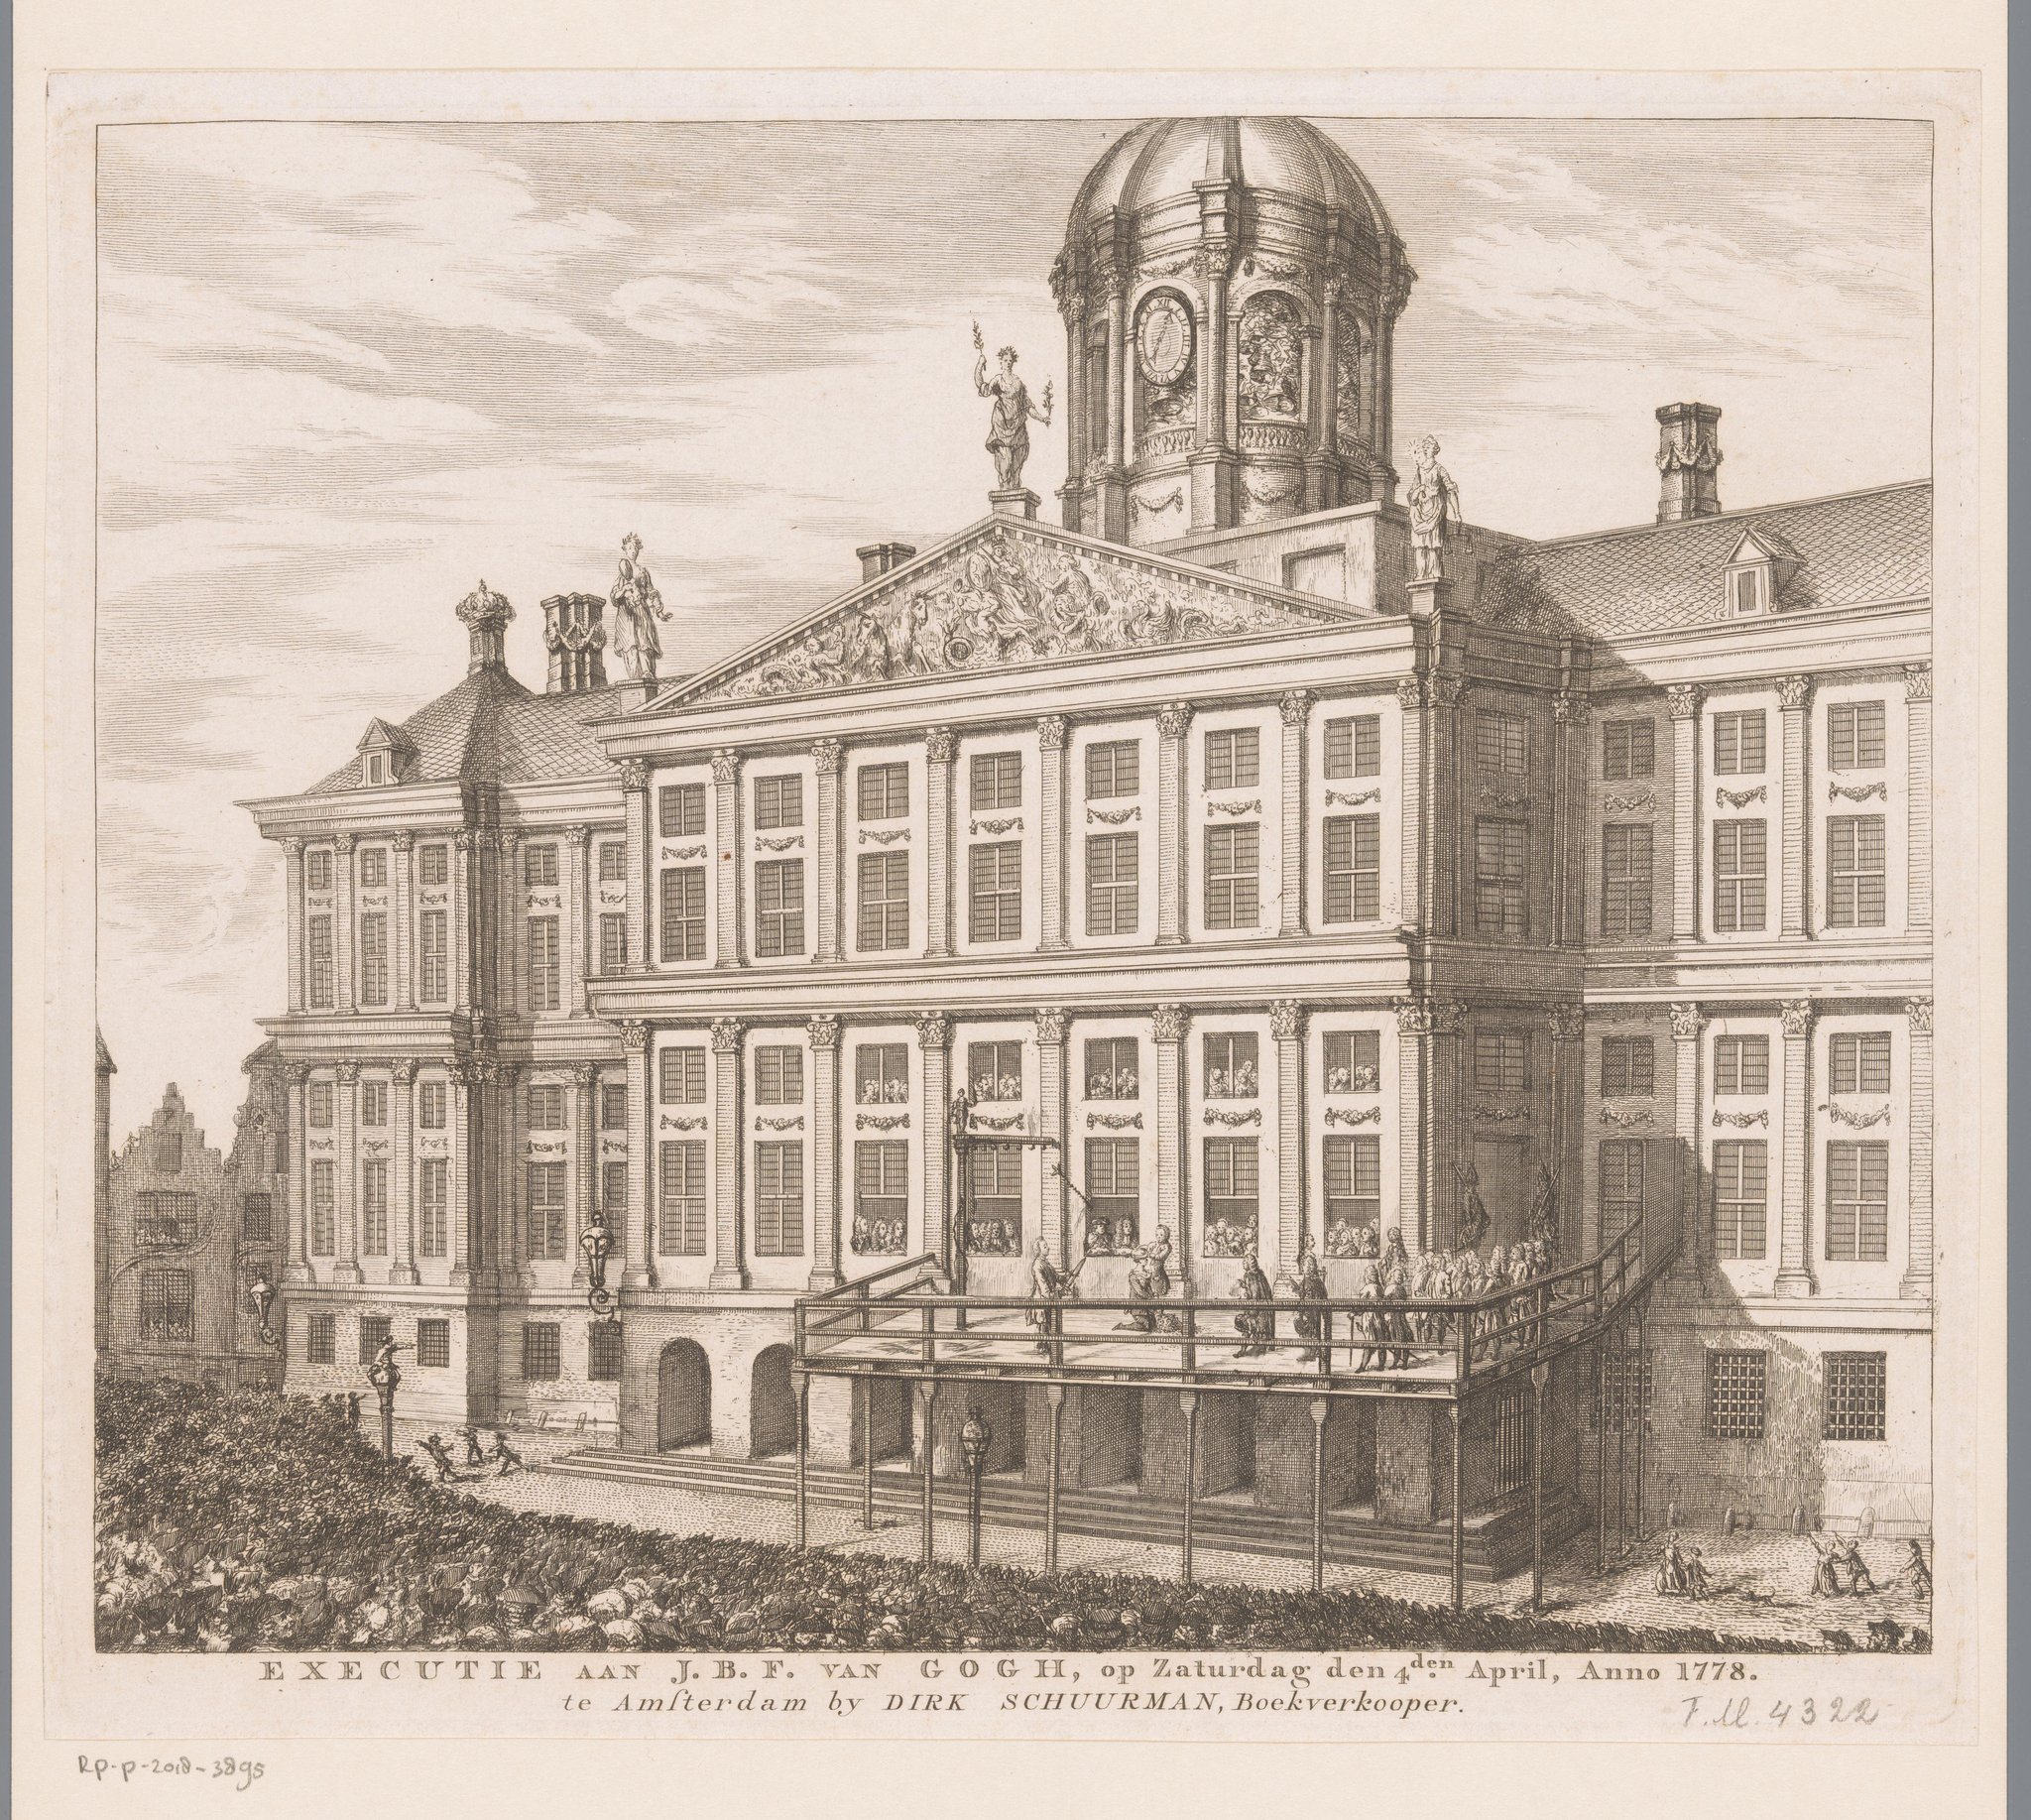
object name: print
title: Executie aan J.B.F. van Gogh, op Zaturdag den 4den April, Anno 1778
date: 1778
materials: paper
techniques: etching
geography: amsterdam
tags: palace, on the scaffold or place of execution, violent death by beheading, royal palace of amsterdam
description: Onthoofding van J.B.F. van Gogh op een schavot voor het Stadhuis op de Dam te Amsterdam, 4 april 1778. Van Gogh is ter dood veroordeeld voor de moord op zijn geliefde Anna Smitshuizen. Op de Dam een grote menigte.